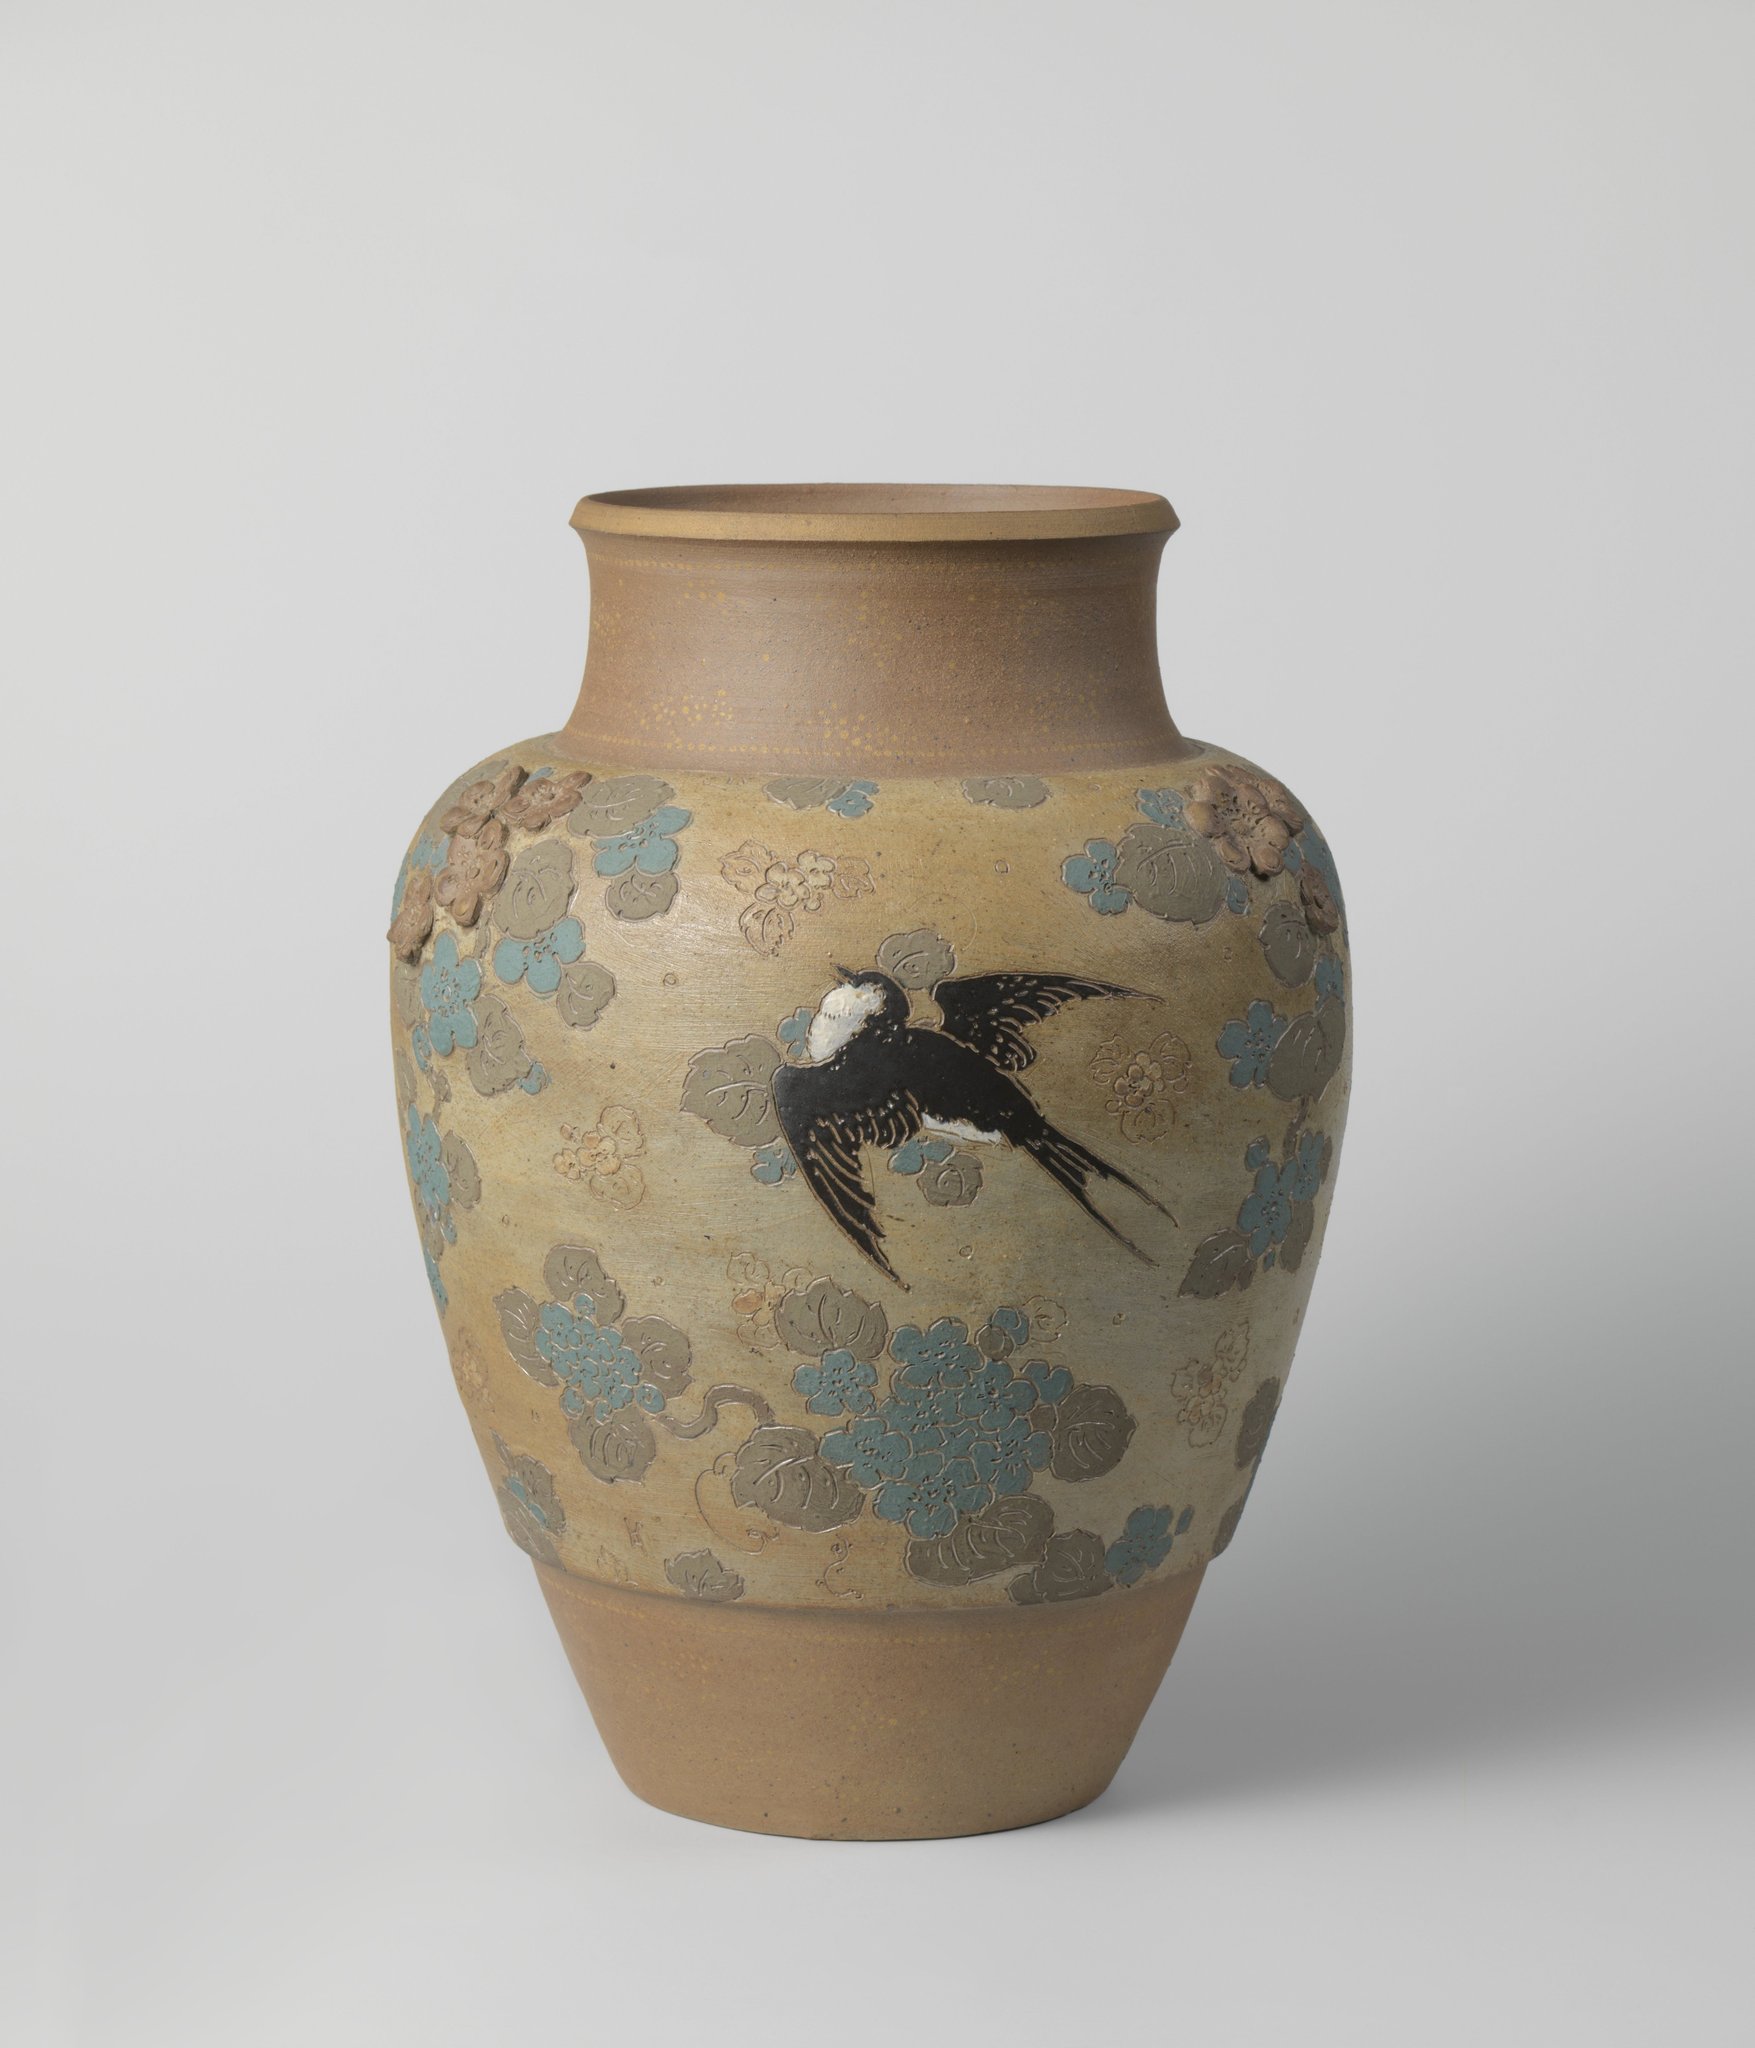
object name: vase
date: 1885-1886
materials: stoneware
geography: paris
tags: song-birds: swallow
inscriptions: mark, monogram: ‘AK’, inscription: ‘HB &Co’, inscription: ‘G2/ B1’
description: Like some painters, such as Van Gogh, potters also derived inspiration from Japanese art. This is evident in the motifs of swallows and Japanese cherry blossoms on this vase, which are incised or modelled in relief. Chaplet was the first to use simple stoneware for art pottery, to which he applied subdued colours using either glazes or slip (thin layers of liquid clay).